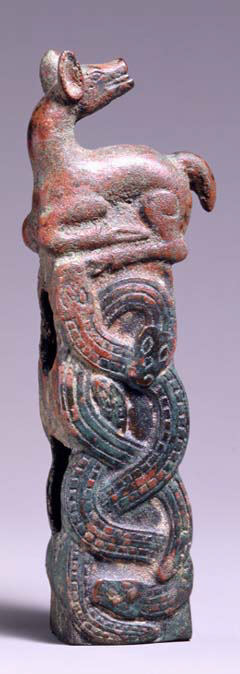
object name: fitting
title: Horse Fitting with Doe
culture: northwest chinese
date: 500-301 BCE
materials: bronze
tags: animals